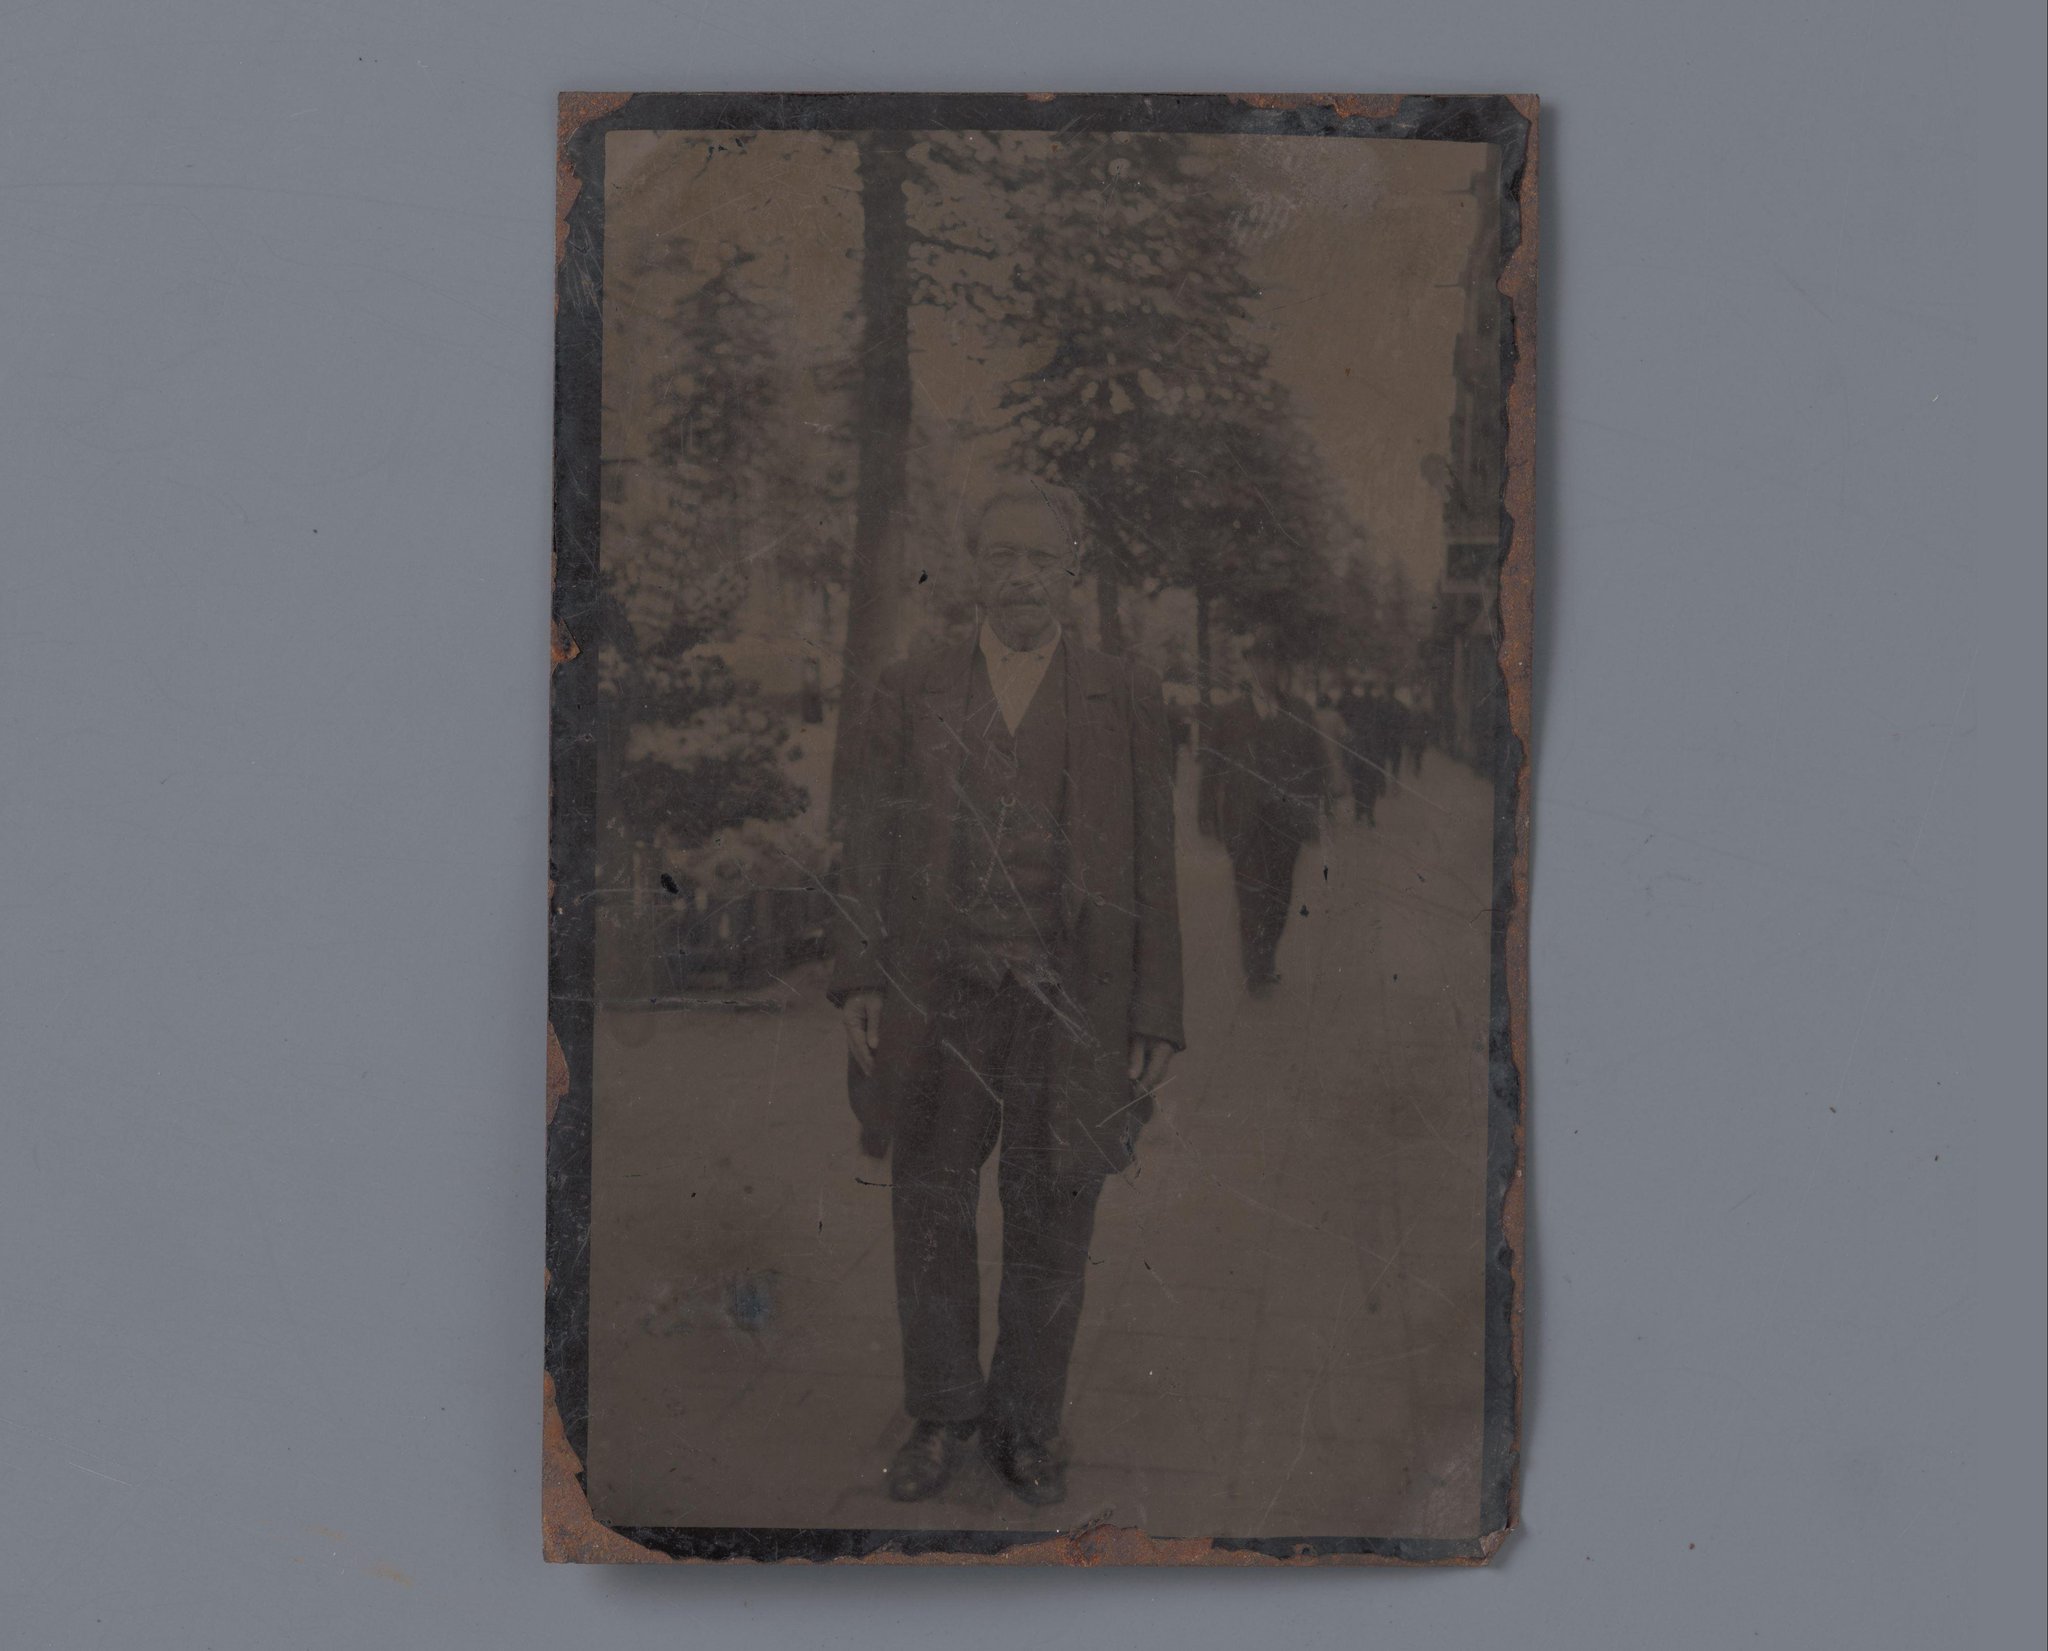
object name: photograph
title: Portret van een onbekende man op straat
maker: Anonymous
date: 1855-1940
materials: iron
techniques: ferrotyping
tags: historical persons, street